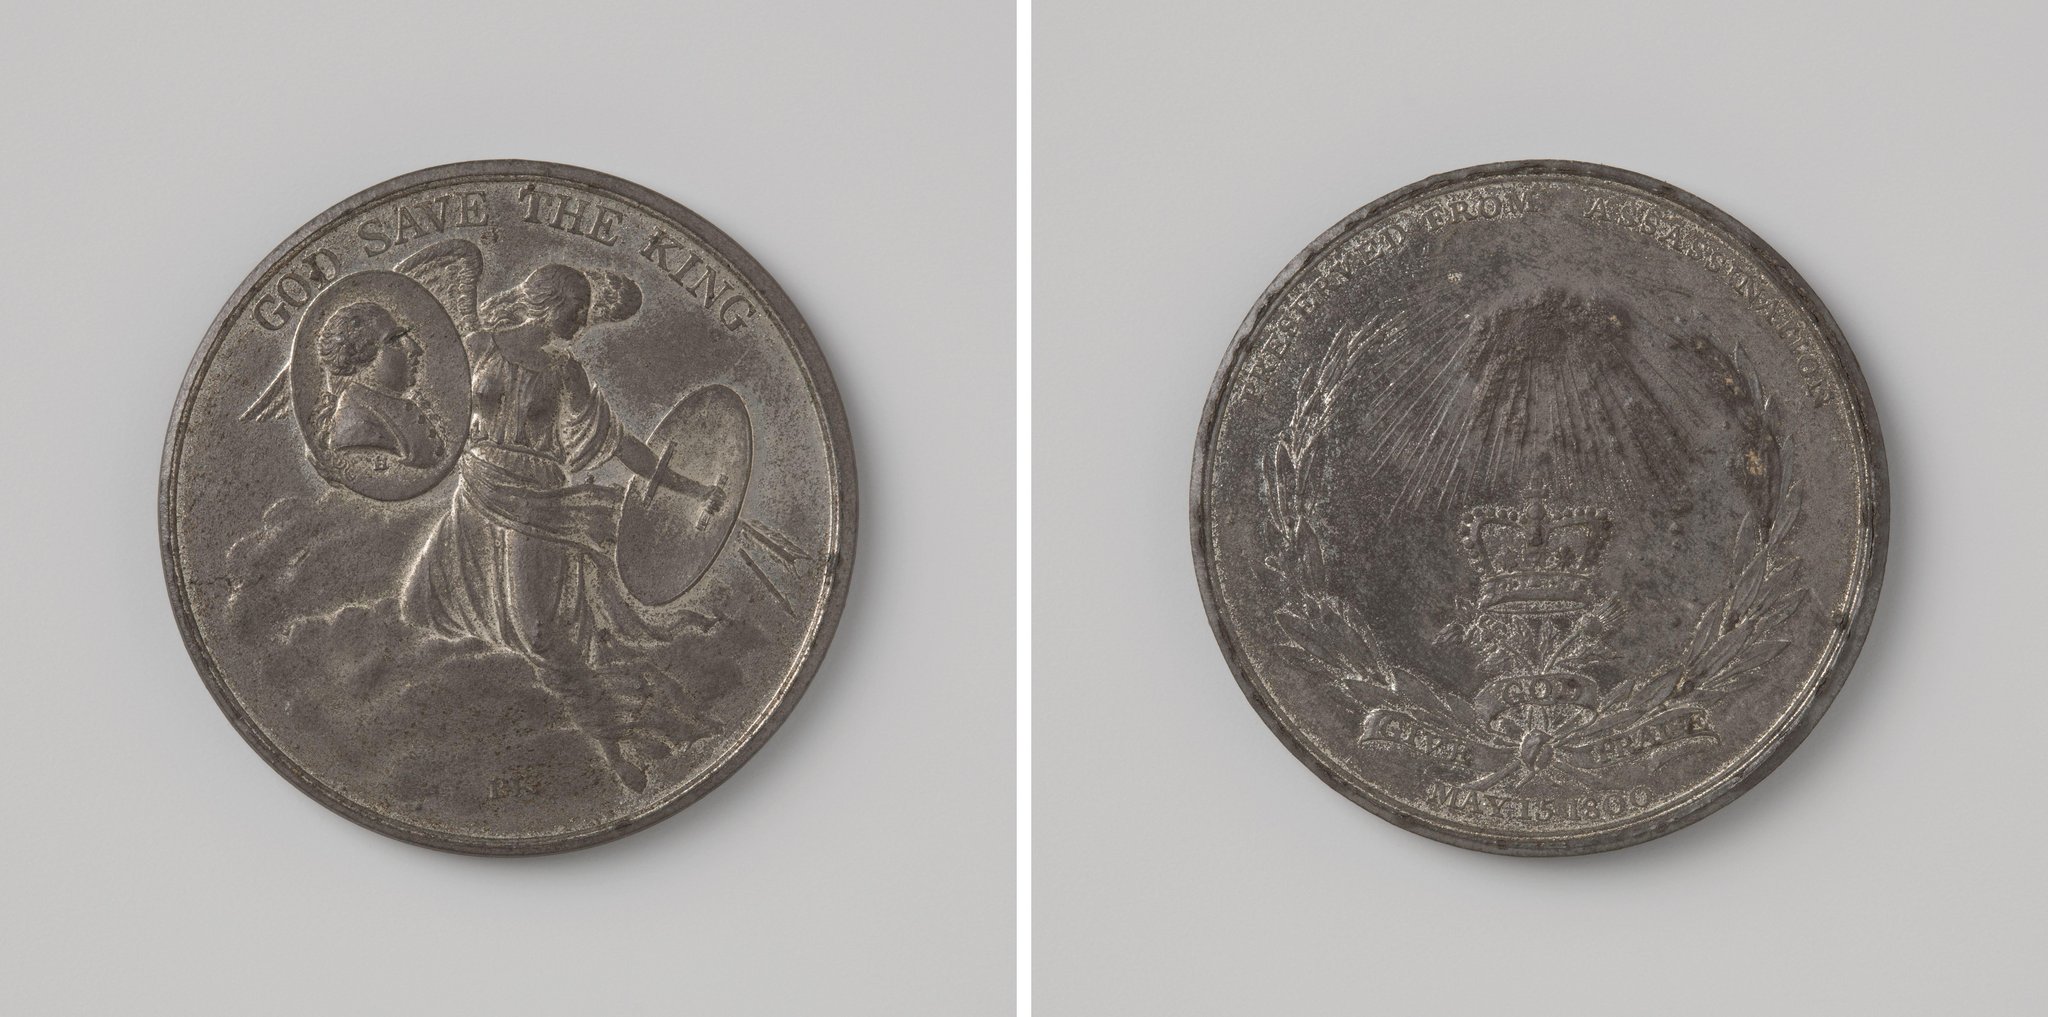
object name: history medal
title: Mislukte aanslag van Mary Nicholson op het leven van George III, koning van Engeland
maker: peter kempson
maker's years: 1792-1820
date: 1800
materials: alloy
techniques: striking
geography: birmingham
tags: george iii (koning van het verenigd koninkrijk), england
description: Penning. Voorzijde: engel met portretmedaillon van koning weert met schild pijlen af binnen omschrift. Keerzijde: bloemen, omwonden door wimpel met opschrift onder kroon beschenen door hemellicht binnen bladerkrans en omschrift.